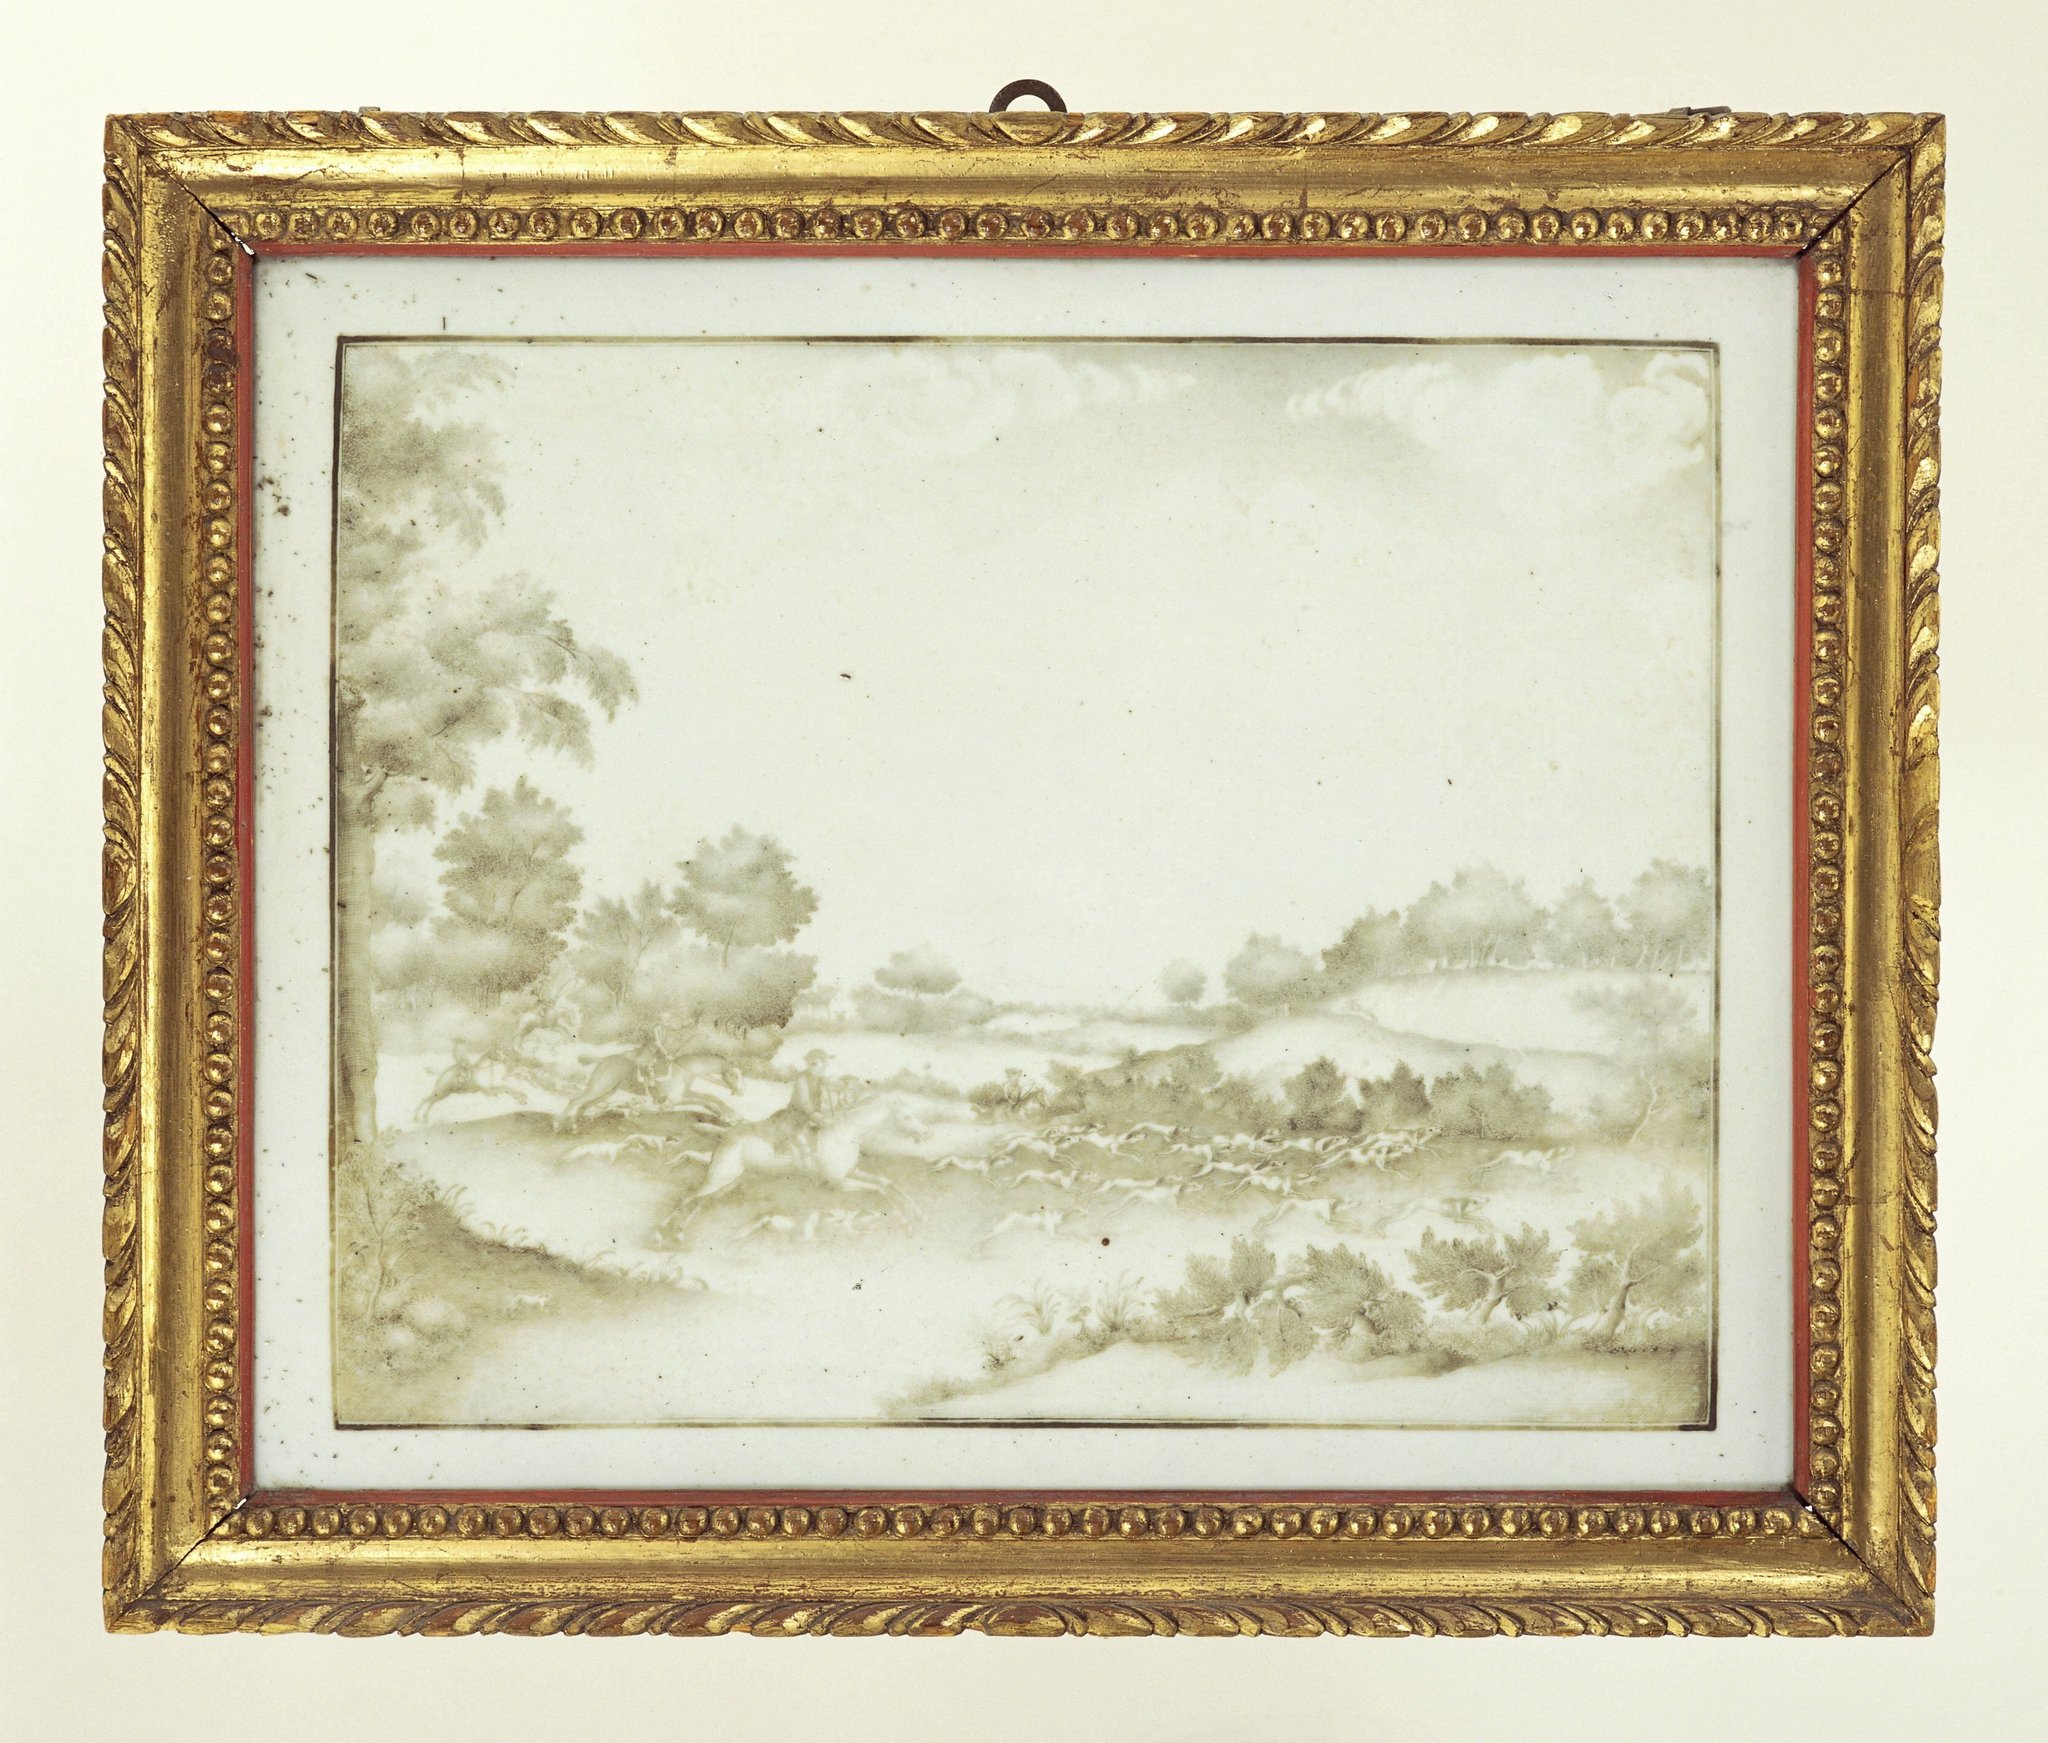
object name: plate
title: Pamel with a hunting scene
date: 1775-1799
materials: glaze, gold, paint, porcelain, wood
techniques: firing, forming, gilding, vitrification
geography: london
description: Rechthoekige plaque van porselein, beschilderd op het glazuur in zwart. Afgebeeld een jachtvoorstelling met vier jagers te paard met hun honden in een landschap. Decoratie naar een prent van Thomas Burford. Originele vergulde lijst. Europese voorstelling in encre de Chine.